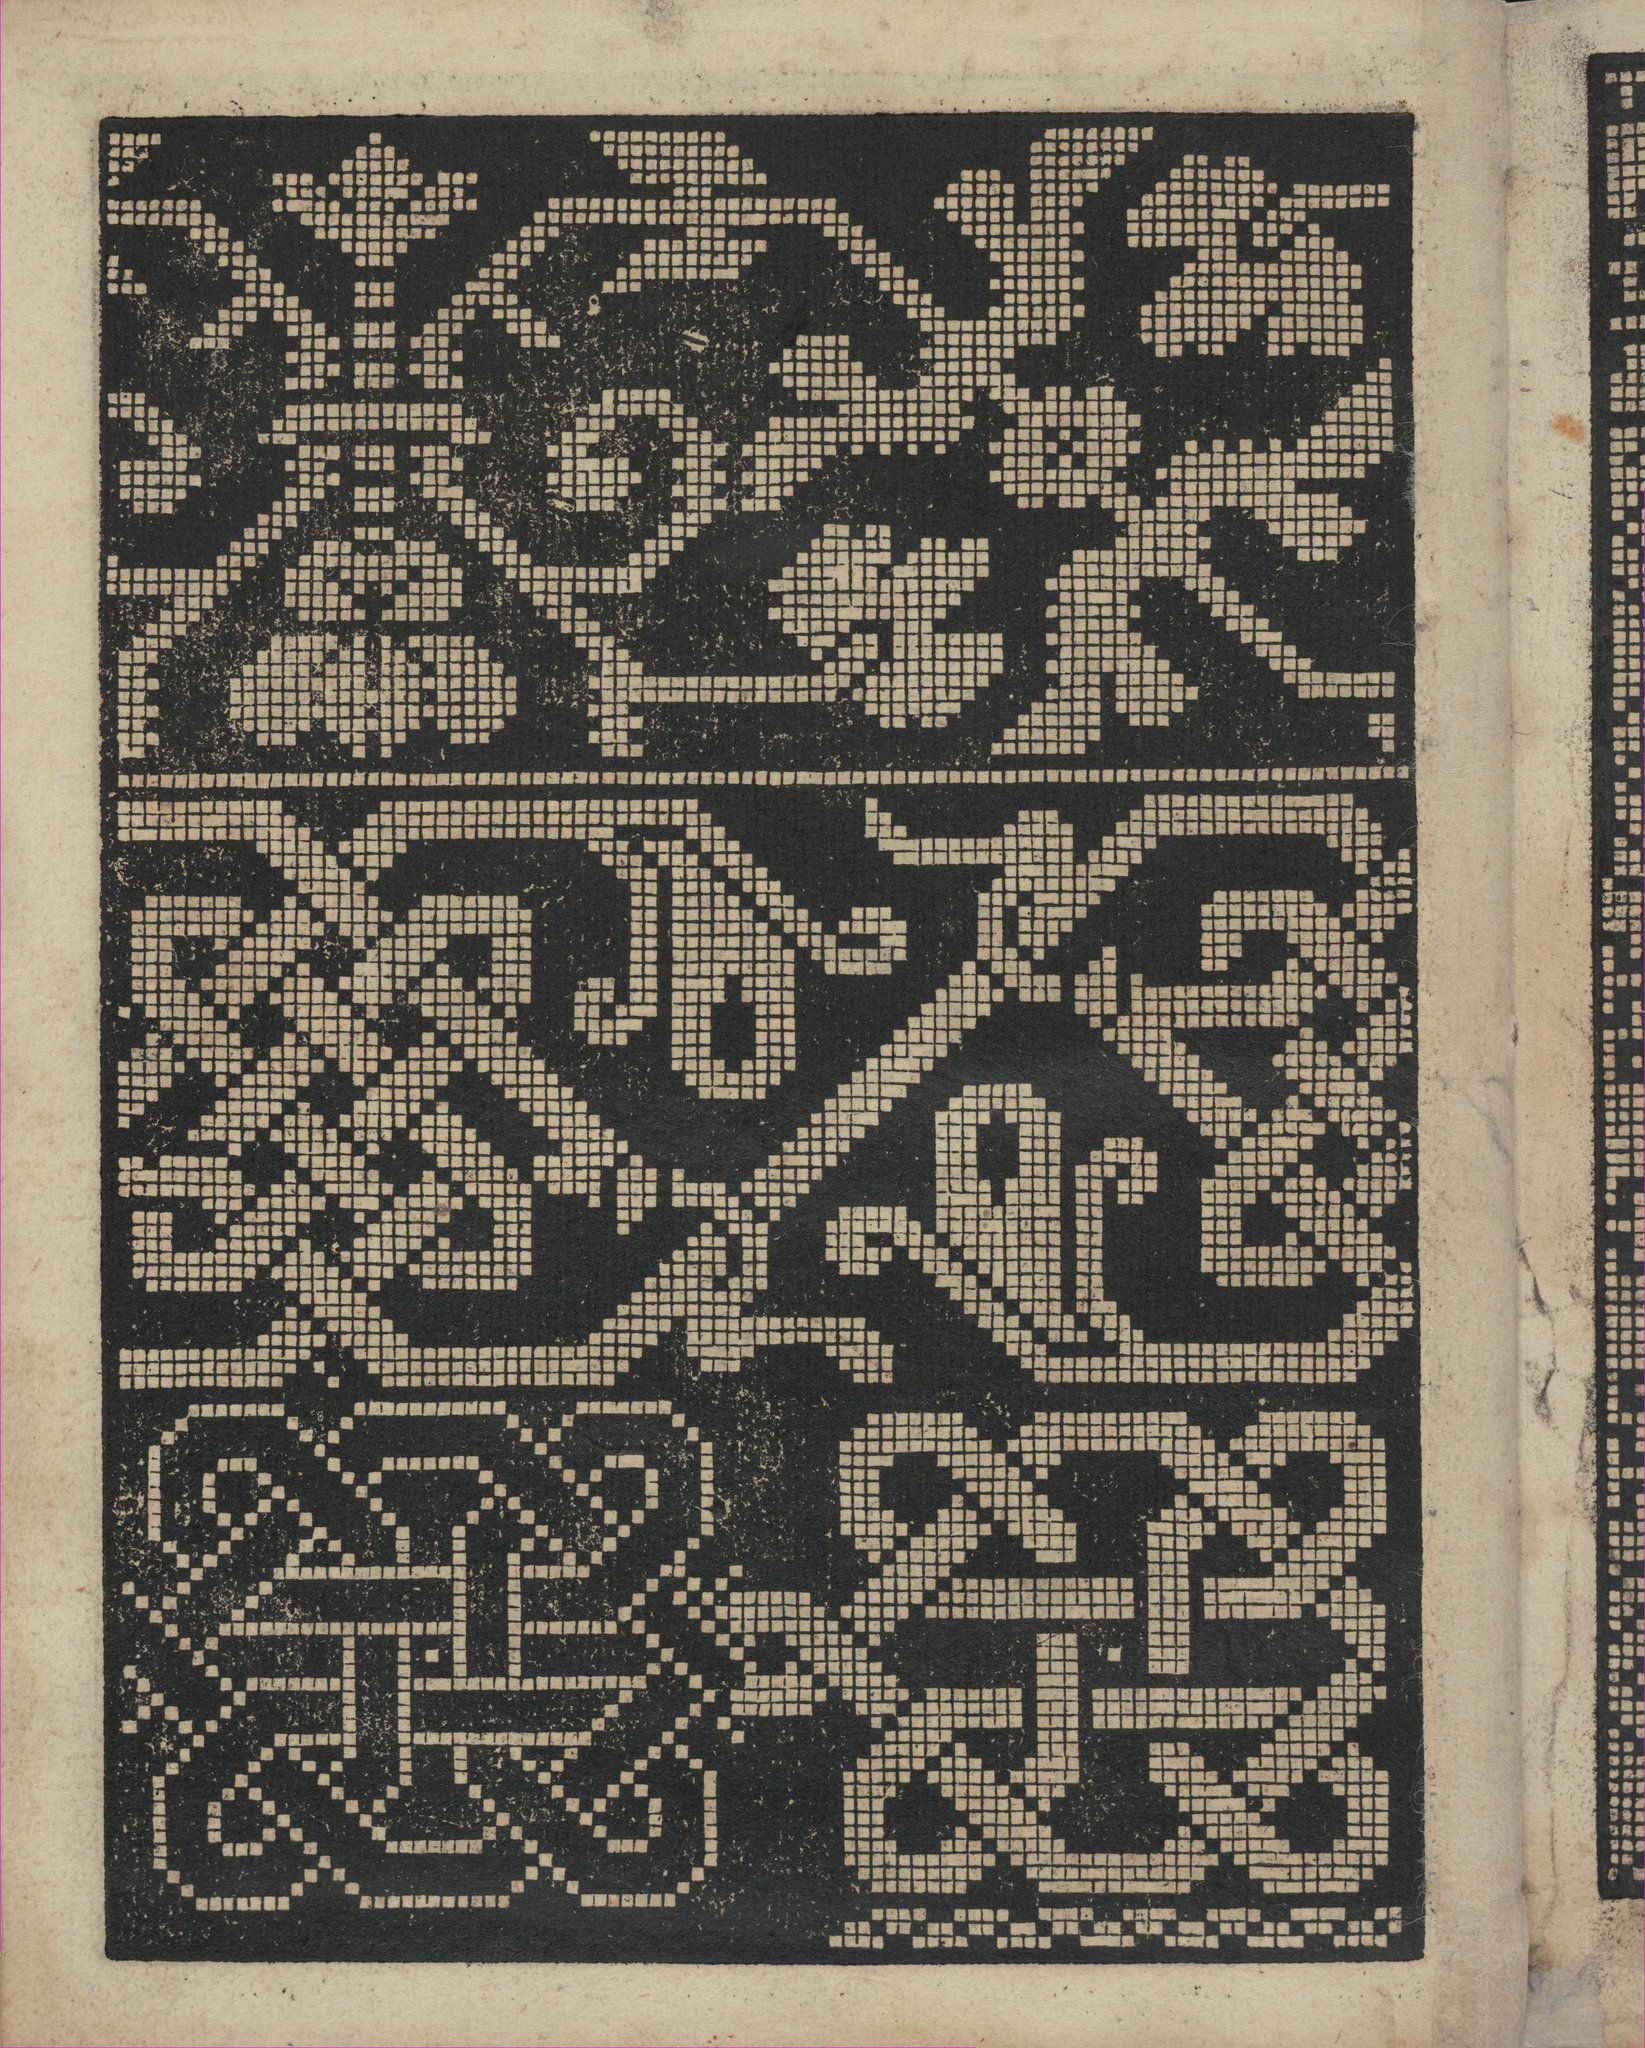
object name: book print ornament architecture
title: Libbretto nouellamete composto per maestro Domenico da Sera...lauorare di ogni sorte di punti, page 16 (verso)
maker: domenico da sera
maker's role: publisher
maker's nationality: french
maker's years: 1500-1599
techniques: woodcut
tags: vines